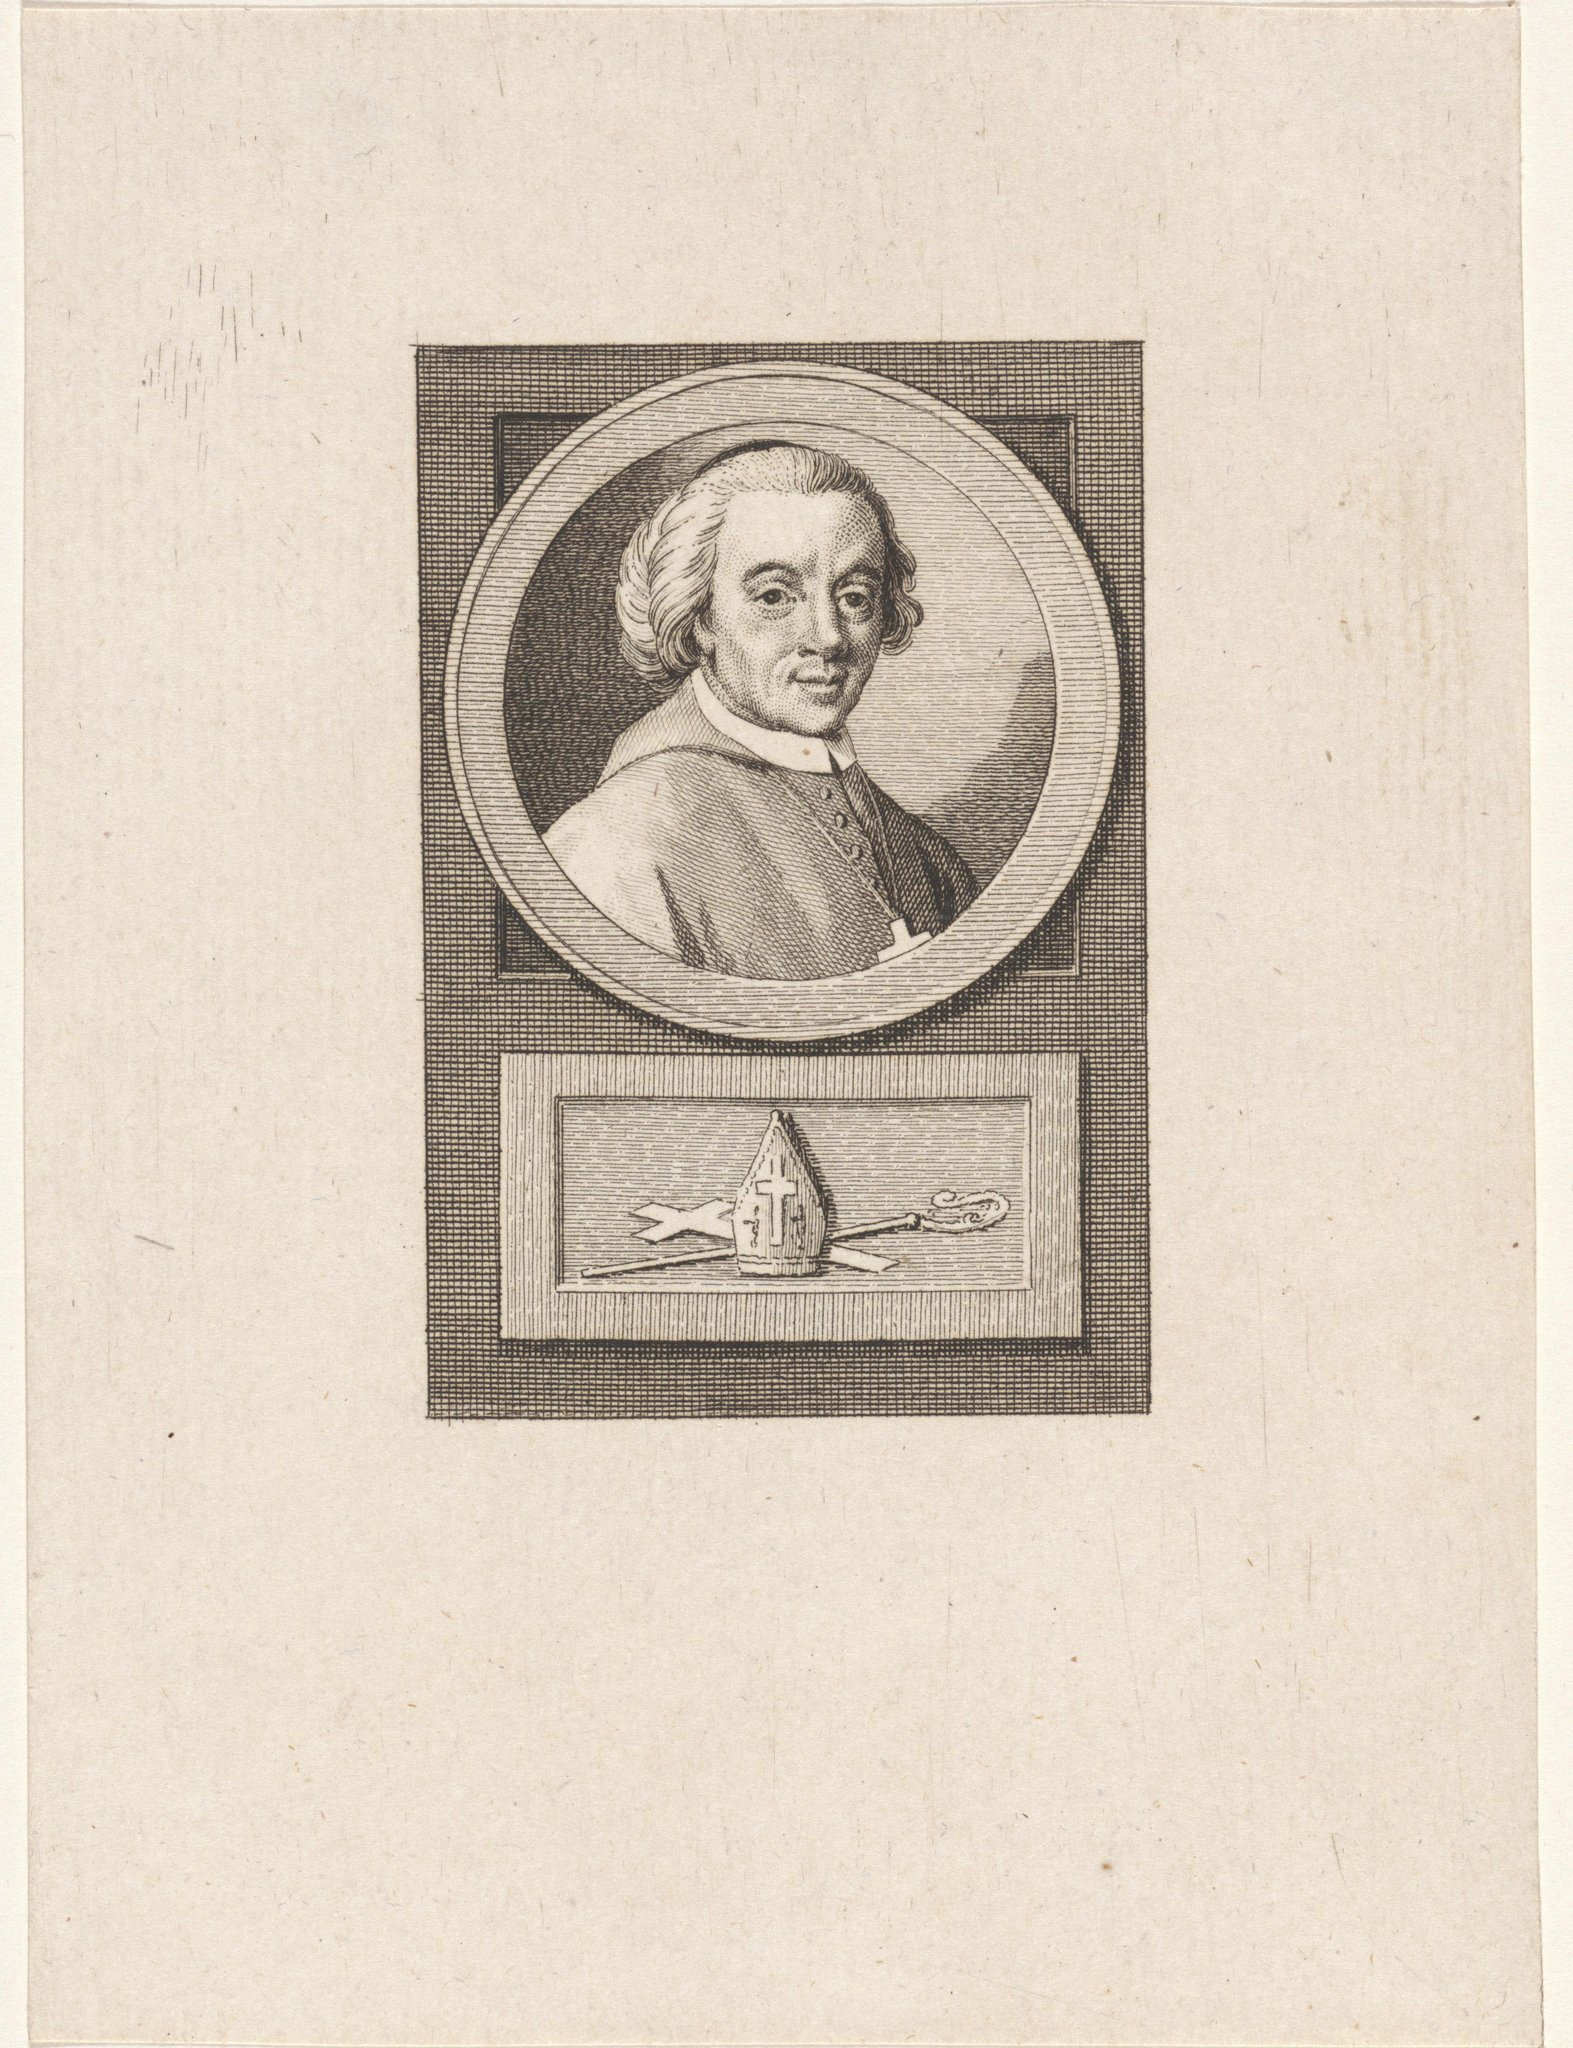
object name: print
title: Portret van Ceasare van Lignano Brancadoro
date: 1783-1795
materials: paper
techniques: engraving, etching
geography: amsterdam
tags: rome, insignia of bishop, e.g. mitre, crozier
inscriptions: collector's mark: Lugt 2228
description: Latere staat prent gebruikt in: Fokke, Jan. Geschiedenissen der Vereenigde Nederlanden voor de vaderlandsche jeugd Ie-XXVste deel. Amsterdam: Johannes Allart, 1783-1795. Deel XXIII.